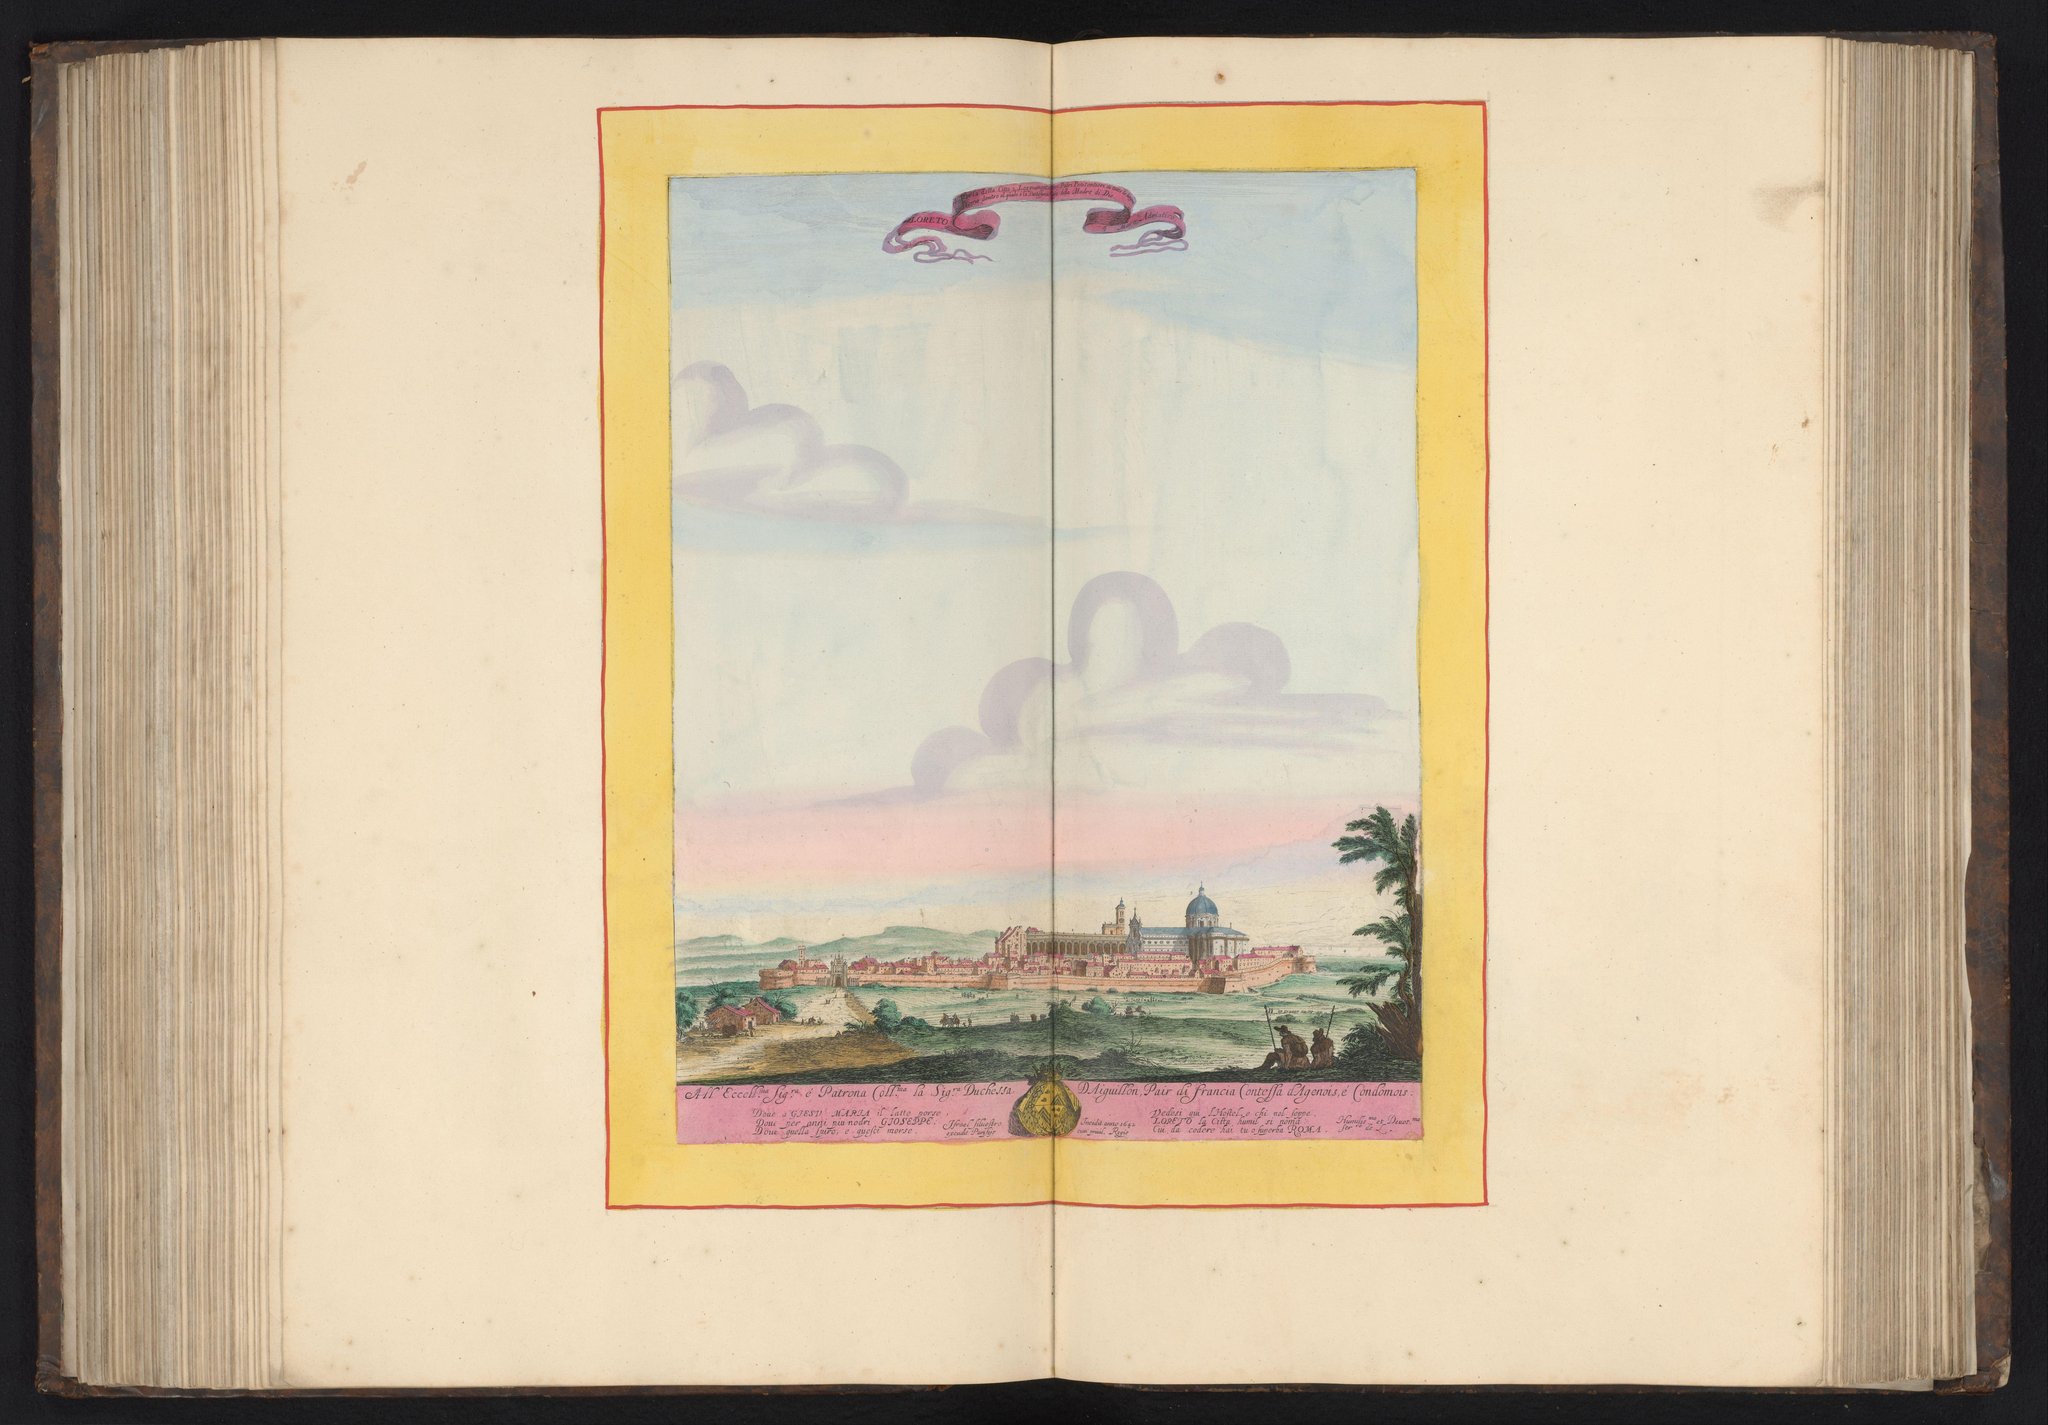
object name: album leaf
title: Gezicht op Loreto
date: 1642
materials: paper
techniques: colour, etching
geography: paris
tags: city-view, and landscape with man-made constructions, church (exterior), city-walls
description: Prent maakt deel uit van een reeks van twaalf prenten van gezichten op antieke en moderne monumenten in Rome. De prent is langs de bovenrand van de voorstelling afgescheurd. De voorstelling is aan de bovenzijde aangevuld met een geschilderde lucht.